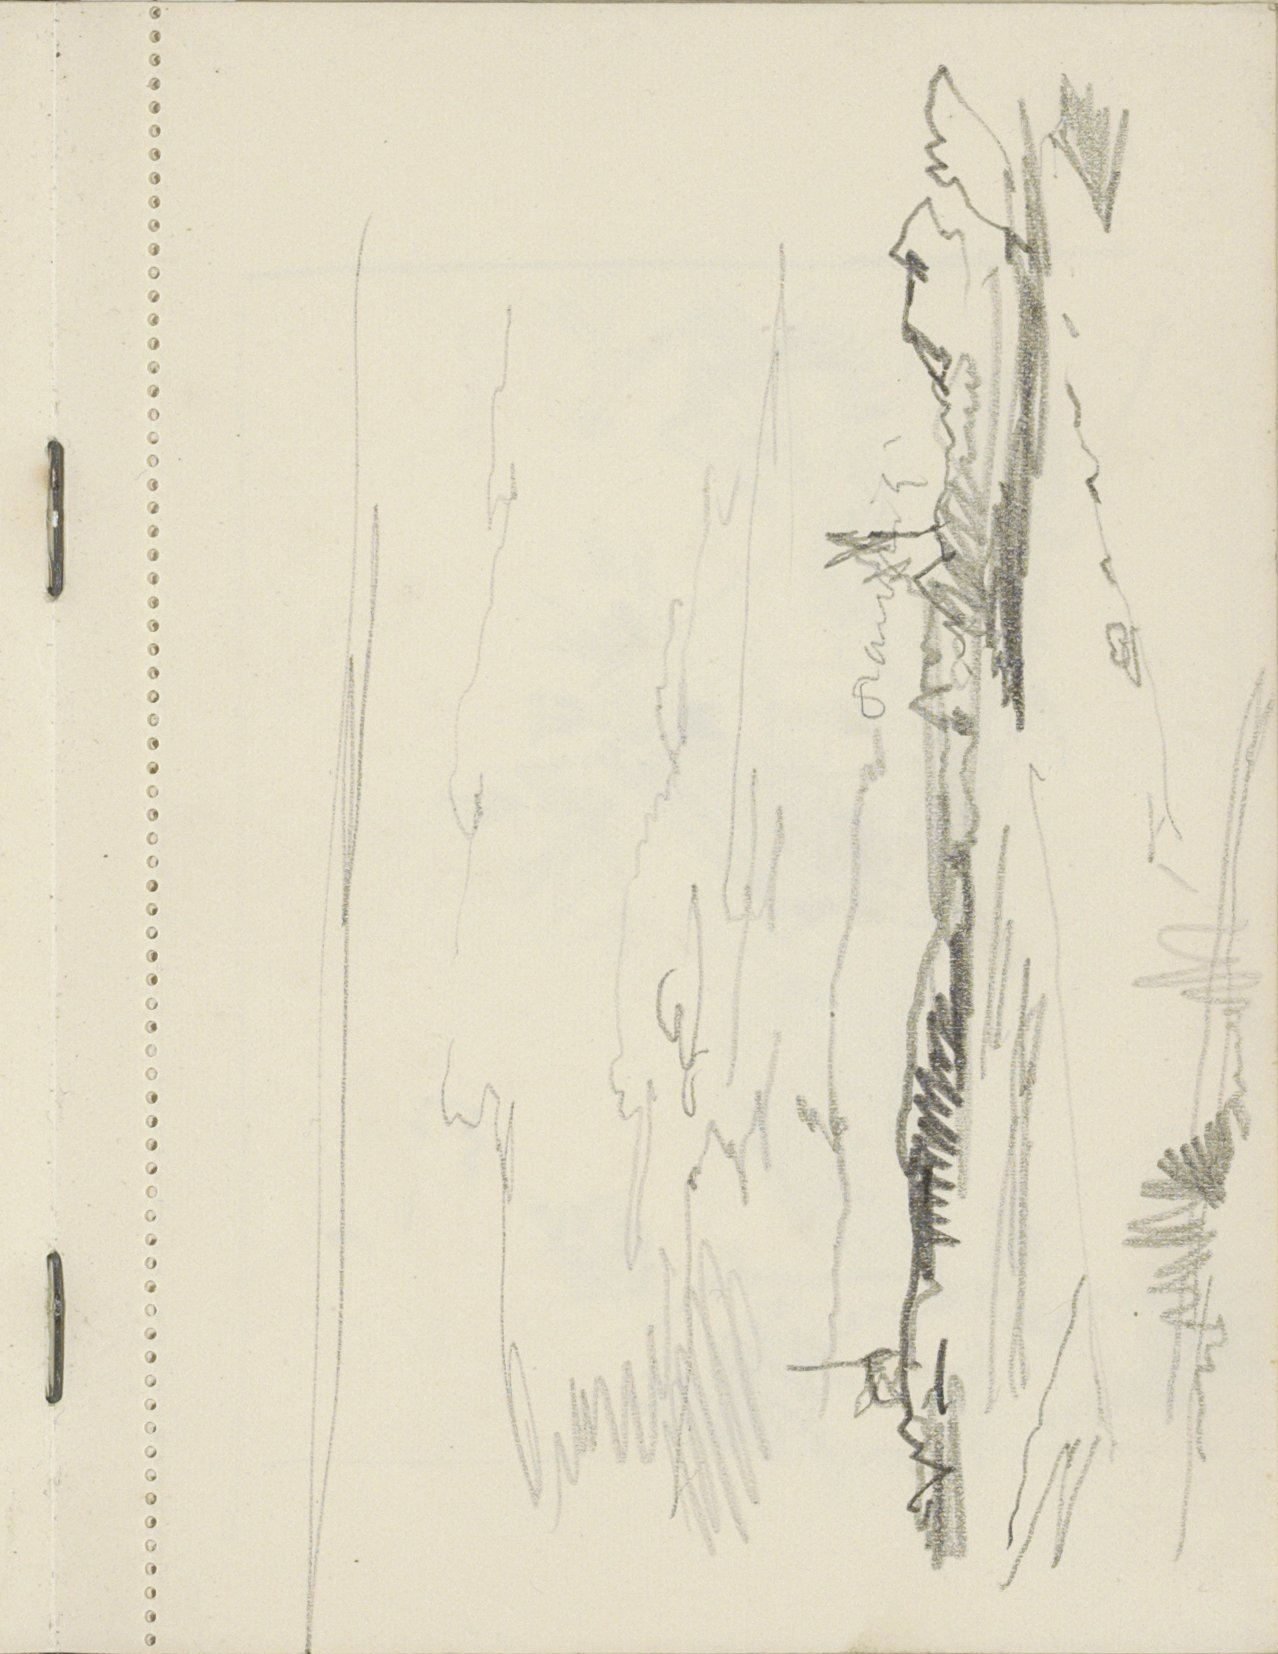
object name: sketchbook leaf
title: Landschap met een molen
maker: cornelis vreedenburgh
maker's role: draughtsman, print maker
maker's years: 1880-1946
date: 1890-1946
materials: paper, pencil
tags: windmill in landscape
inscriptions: kleurnotitie, handgeschreven in potlood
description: Blad 7 recto uit een schetsboek met 71 bladen.